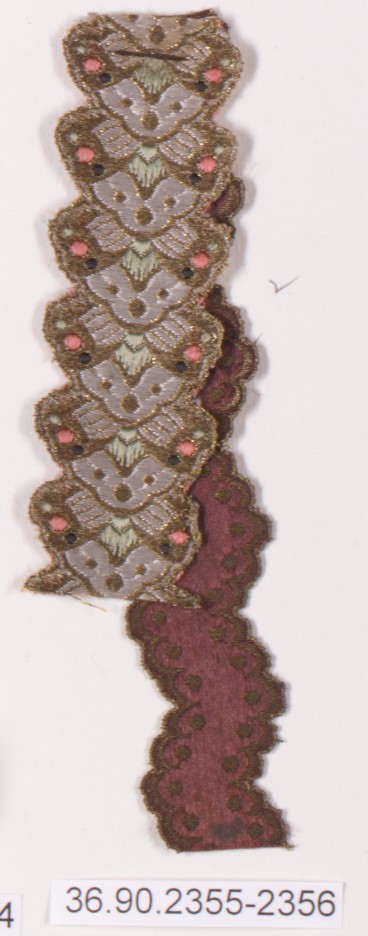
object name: ribbon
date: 1801-1900